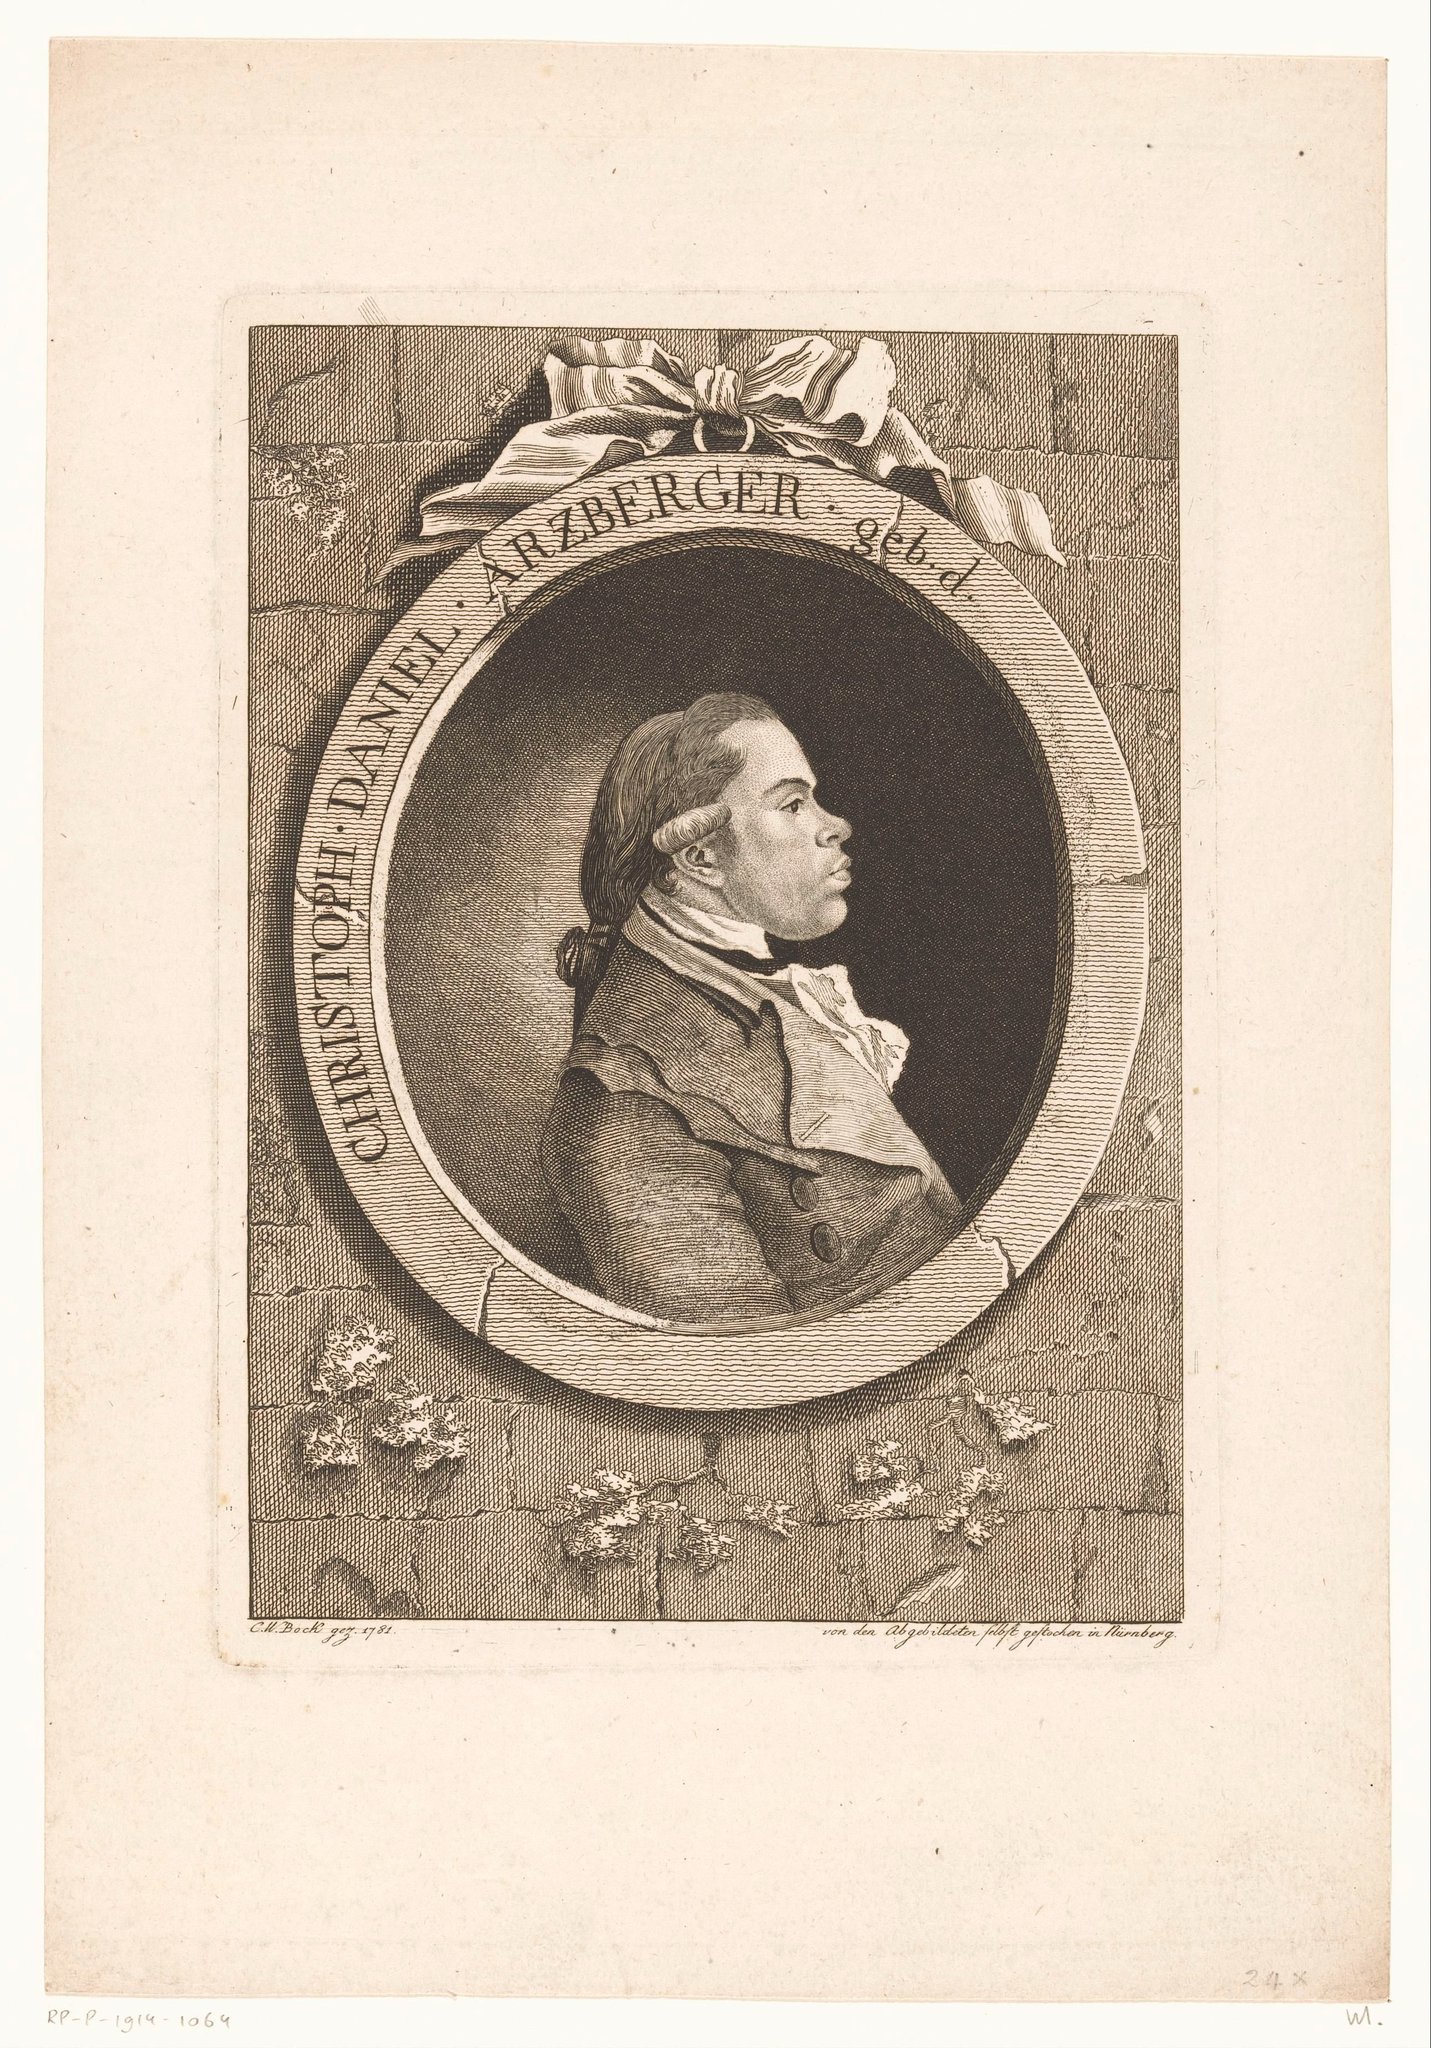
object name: print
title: Zelfportret van Christoph Daniel Arzberger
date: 1781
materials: paper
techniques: engraving, etching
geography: nuremberg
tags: print maker, christoph daniel arzberger, portrait, self-portrait of artist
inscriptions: collector's mark: Lugt 2228